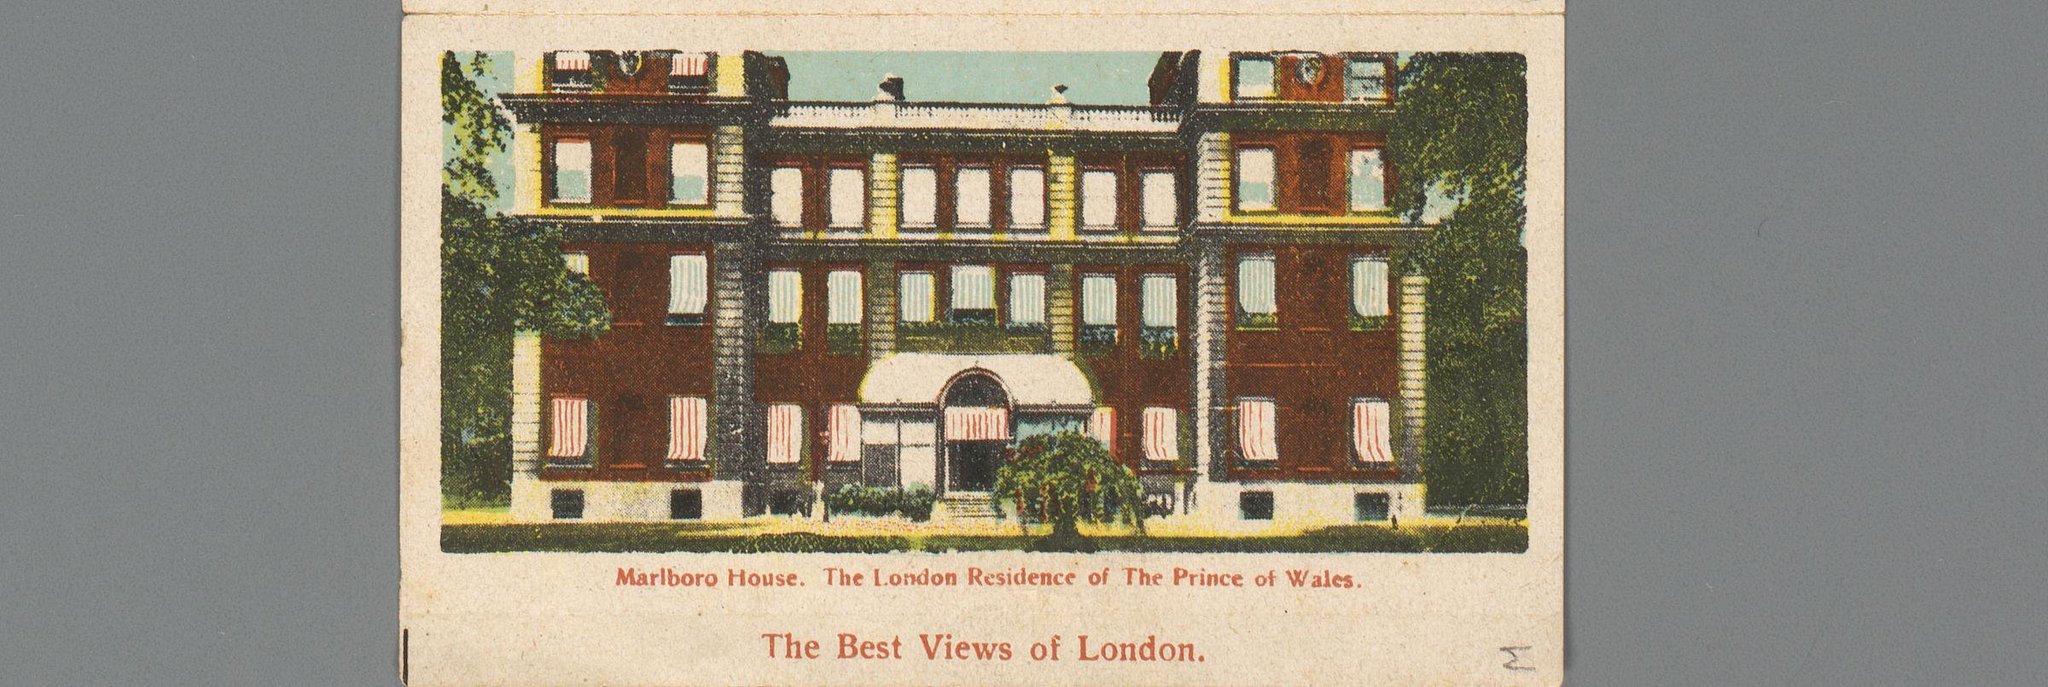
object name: album leaf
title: Marlboro House. The London Residence of the Prince of Wales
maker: Anonymous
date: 1888-1914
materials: paper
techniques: autotype, chromophotolithography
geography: london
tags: palace, london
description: Deze prent maakt deel uit van een album.